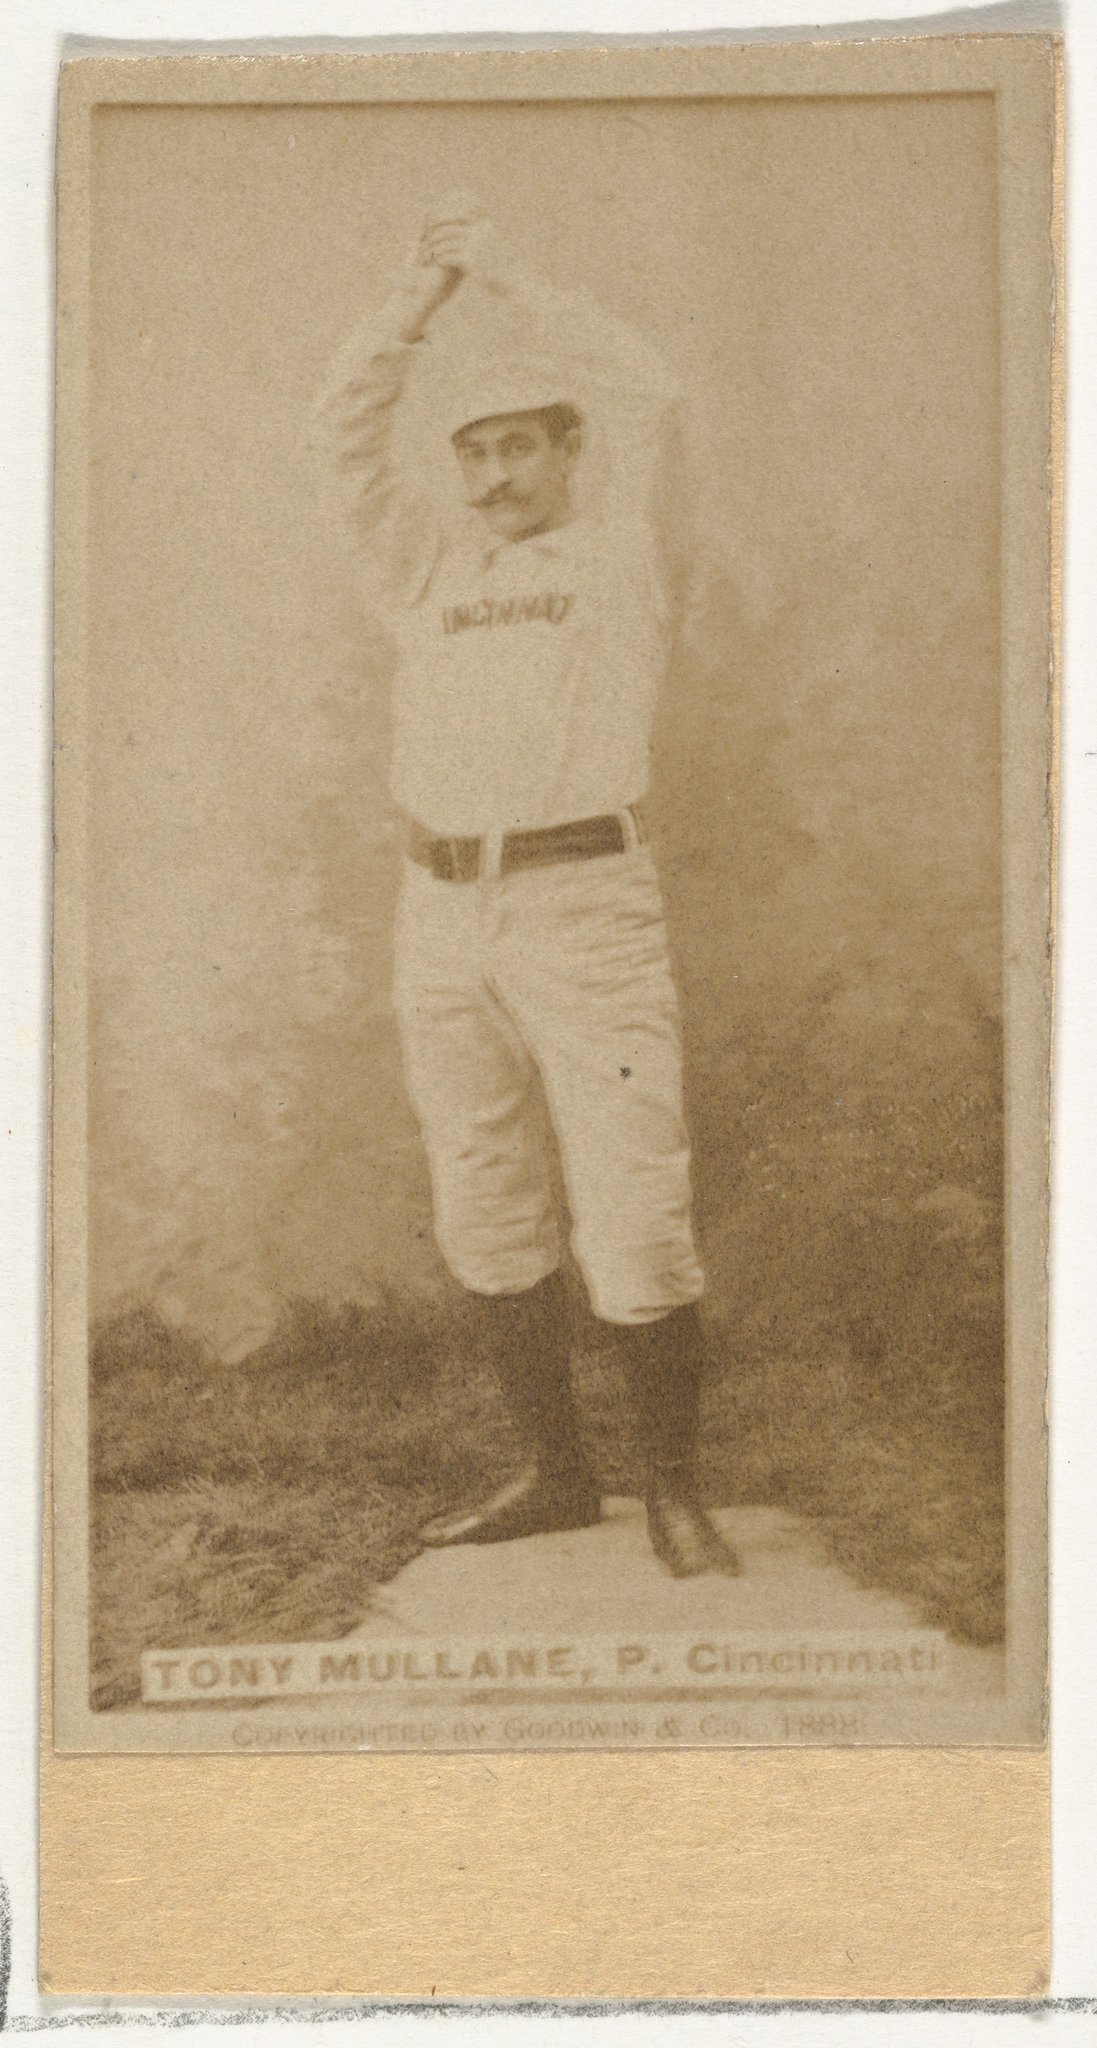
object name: baseball card, photograph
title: Anthony John "Tony" Mullane, Pitcher, Cincinnati, from the Old Judge series (N172) for Old Judge Cigarettes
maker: goodwin & company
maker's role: publisher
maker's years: 1850-1950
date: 1888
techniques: albumen silver print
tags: men,baseball,athletes